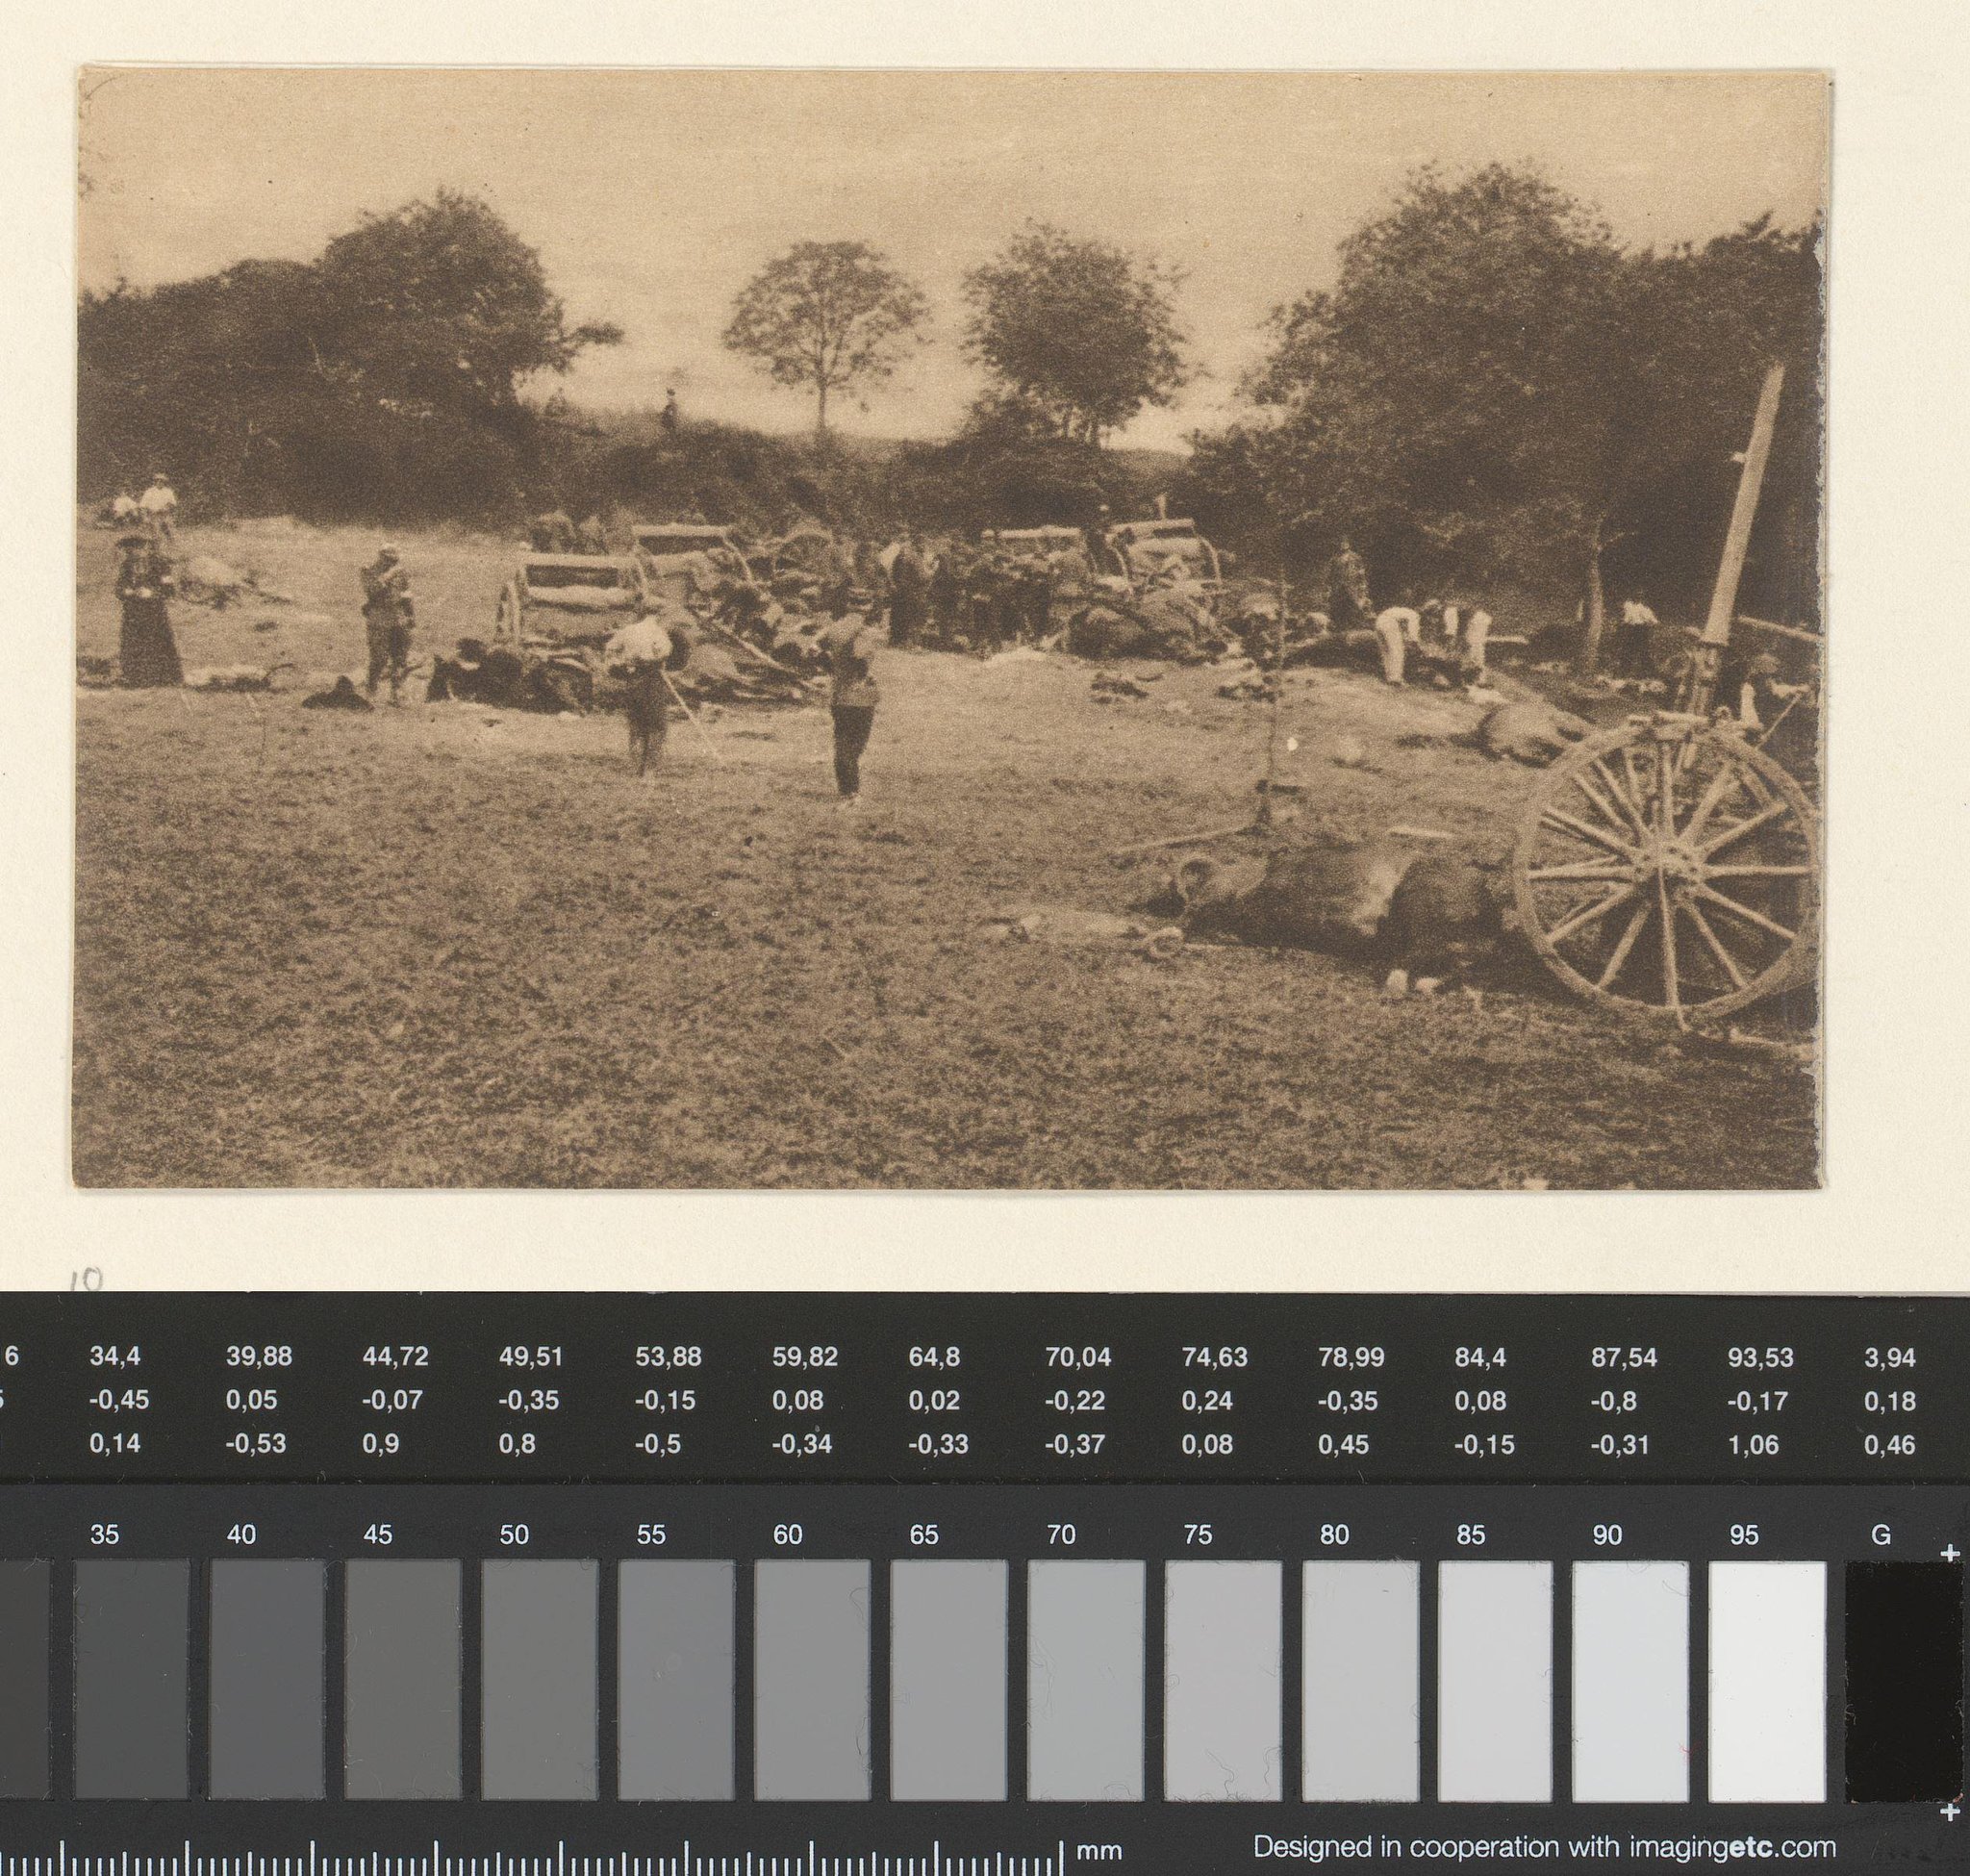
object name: ansichtkaart, prentbriefkaart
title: Eene batterij Duitsche "77" door de geduchte Fransche "75" in stukken geschoten (...)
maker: sémaphore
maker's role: printer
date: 1914-1915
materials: paper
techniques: photograph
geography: marseille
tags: firearms: cannon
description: Vernietigd Duitse geschut. Onderdeel van de eerste serie van twaalf (elf aanwezig) prentbriefkaarten over de Eerste Wereldoorlog, 1914-1915.